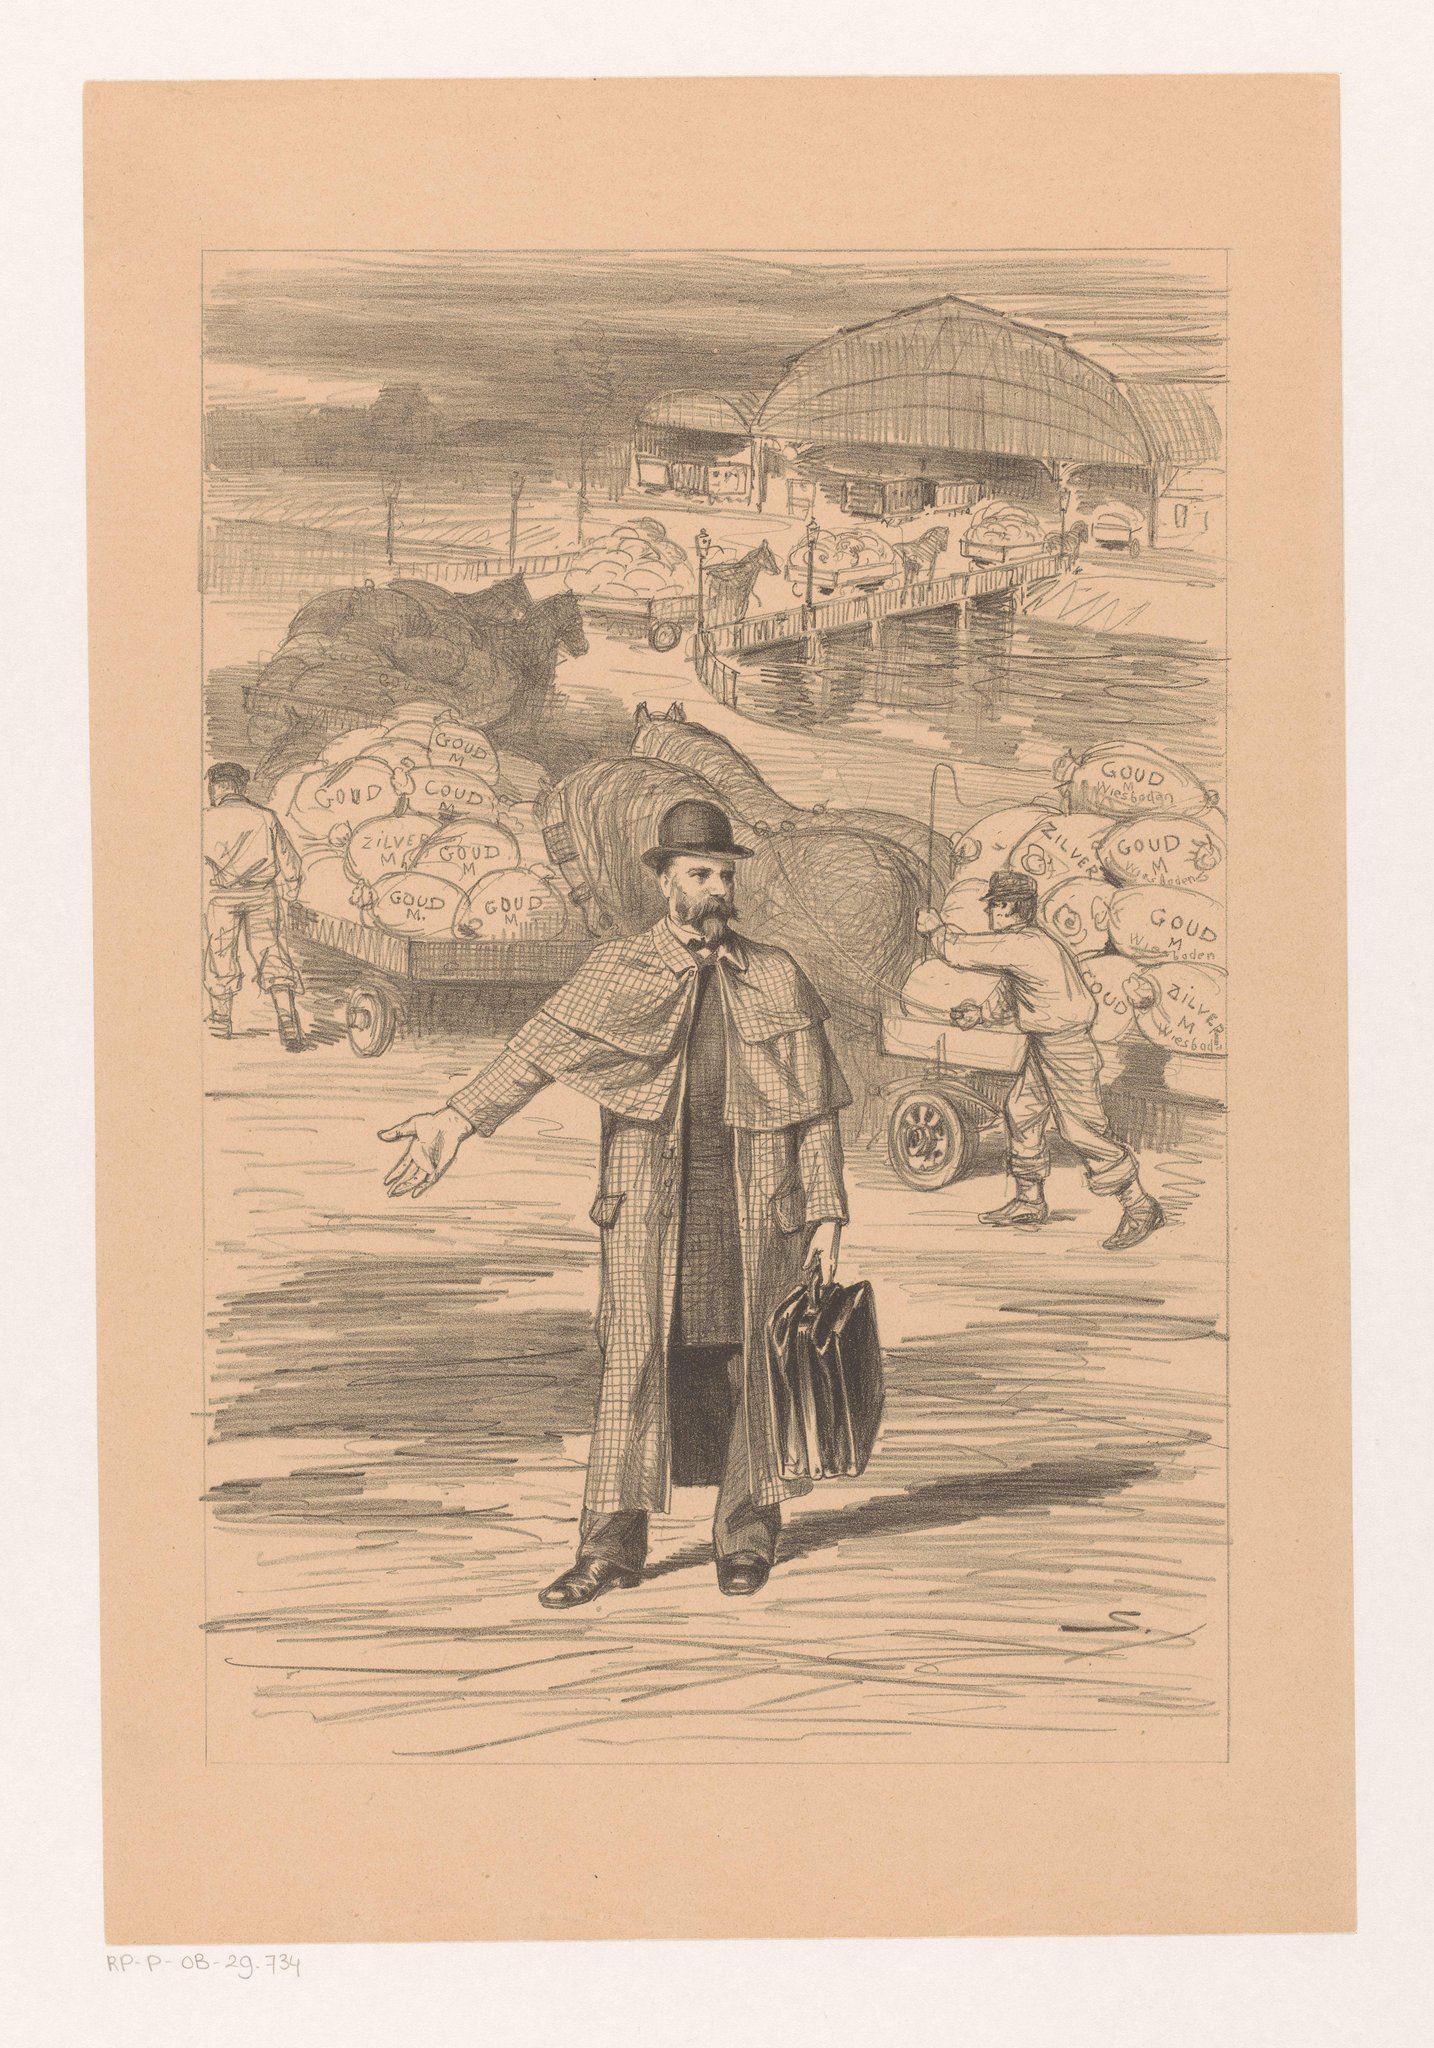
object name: print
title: Spotprent op het vertrek van Johann Georg Mezger uit Amsterdam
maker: willem steelink (ii)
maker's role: draughtsman, print maker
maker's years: 1856-1928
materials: paper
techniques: lithograph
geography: netherlands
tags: amsterdam, physician, doctor, taking leave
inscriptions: collector's mark: Lugt 2228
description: Dokter Johann Georg Mezger vertrekt in 1888 van Amsterdam naar Wiesbaden. Achter hem worden karren vol goud en zilver, dat hij met zijn dokterspraktijken heeft verdiend, richting het station gebracht.